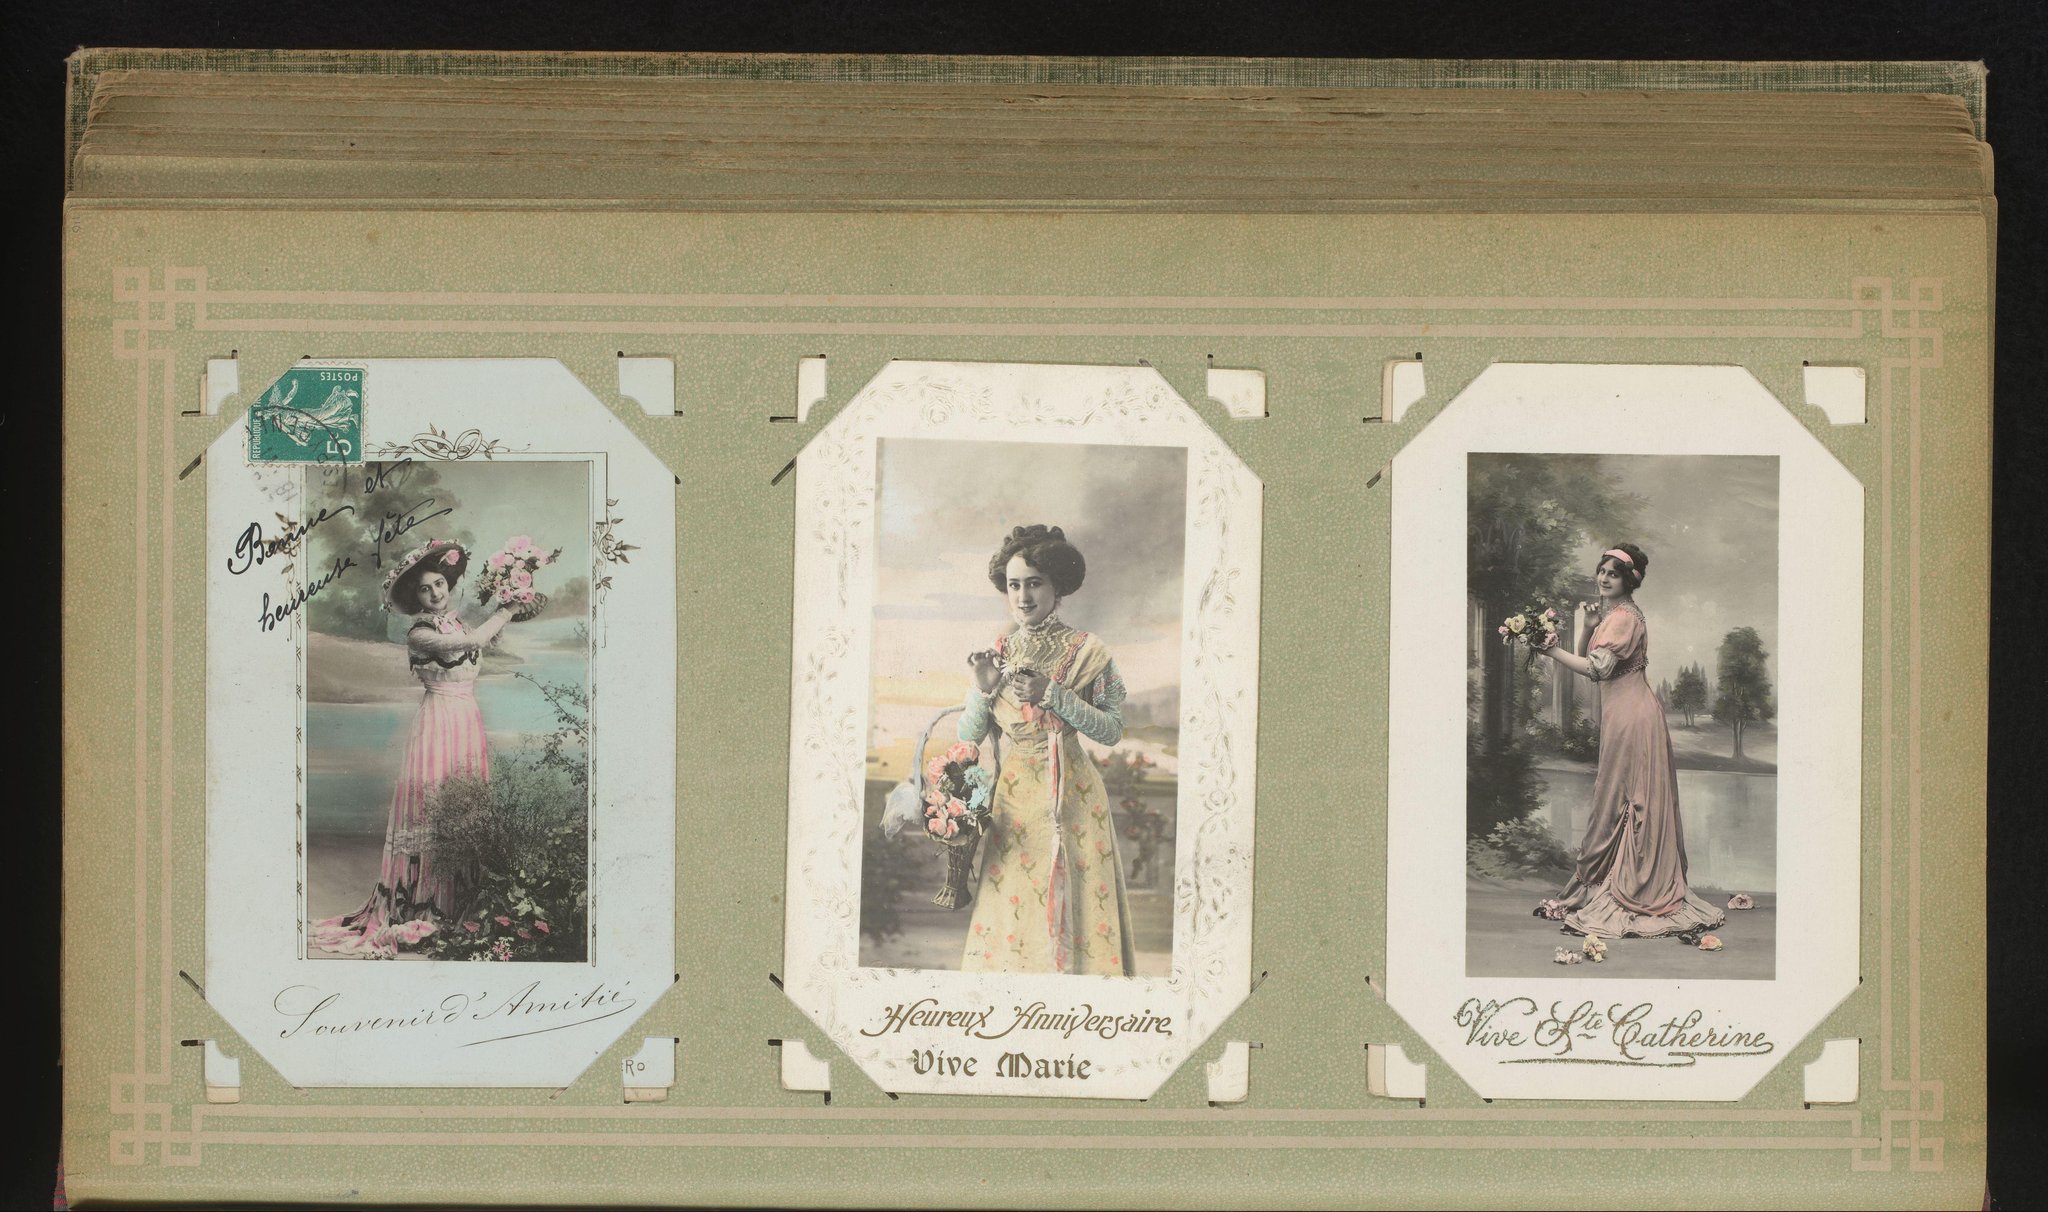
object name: ansichtkaart, prentbriefkaart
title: Drie portretten van vrouwen met bloemen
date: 1900-1930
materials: cardboard, ink, photographic support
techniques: gelatin silver print, hand coloring, pen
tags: flowers, historical persons - bb - woman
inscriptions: monogram: ‘AéRo’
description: Deze foto's maken deel uit van een album.